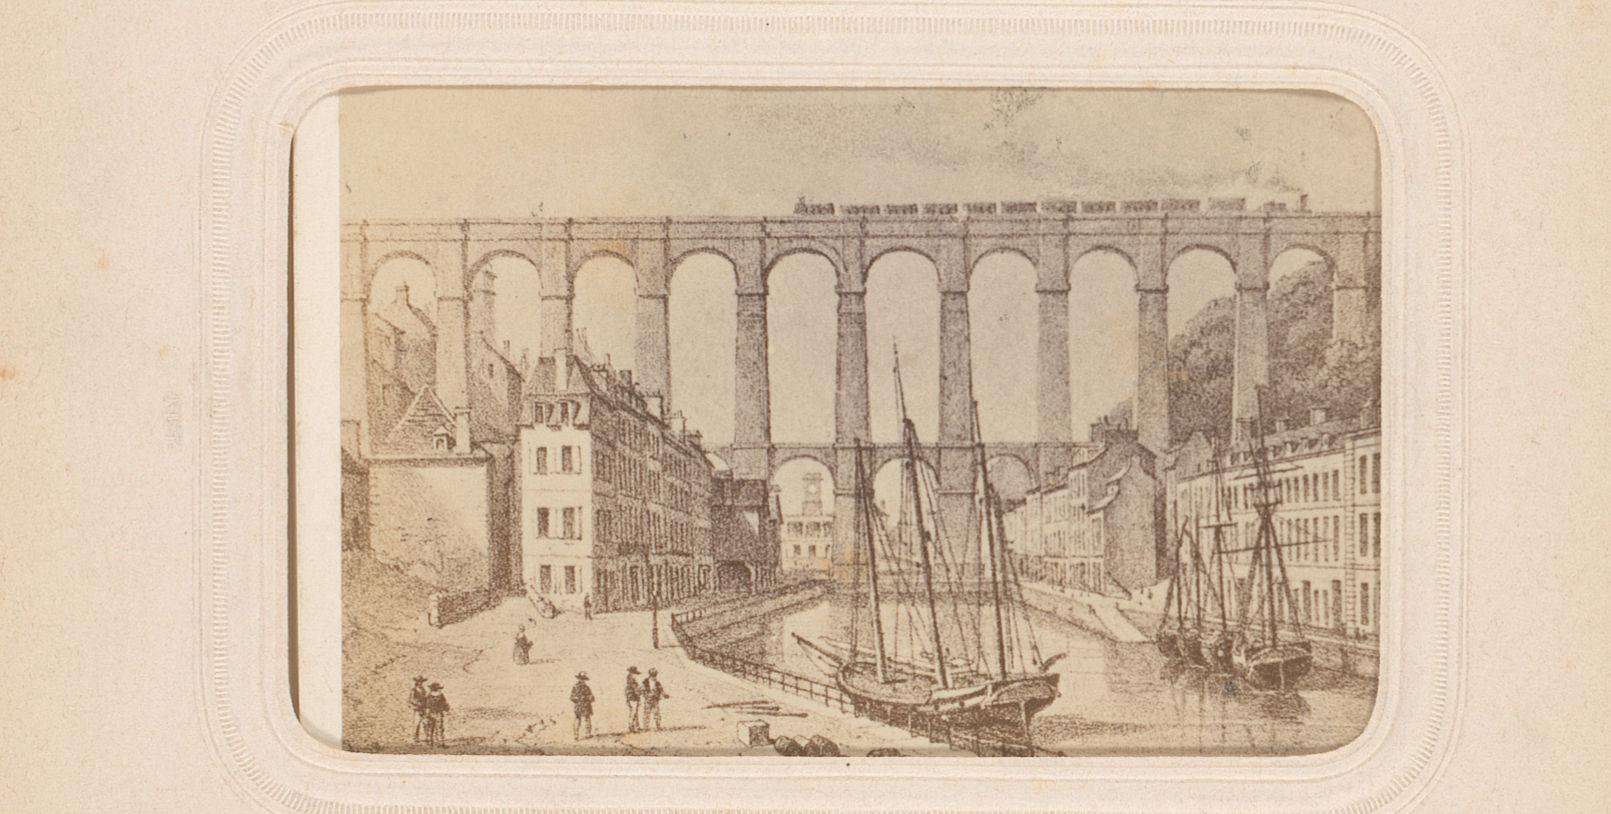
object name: photograph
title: Fotoreproductie van een prent van Viaduc de Morlaix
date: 1860-1900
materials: cardboard, photographic support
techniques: albumen print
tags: viaduct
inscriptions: inscription: ‘F. Sinnett, Editeur/ 17, Rue d'Agenteuil/ Taupin, Photographe/ Paris’